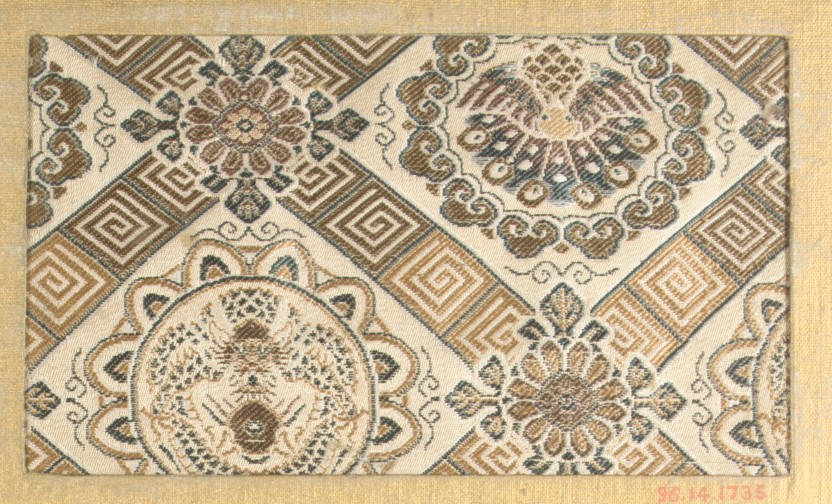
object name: piece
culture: japanese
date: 1701-1900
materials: silk